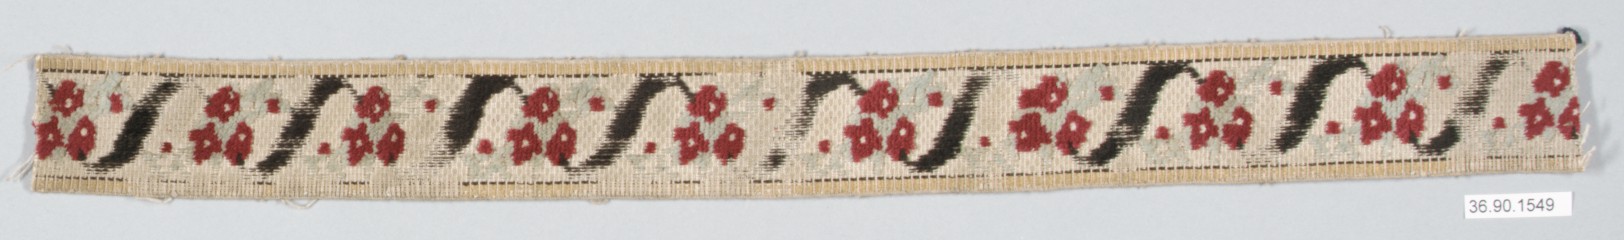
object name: galloon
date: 1701-1900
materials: silk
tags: flowers